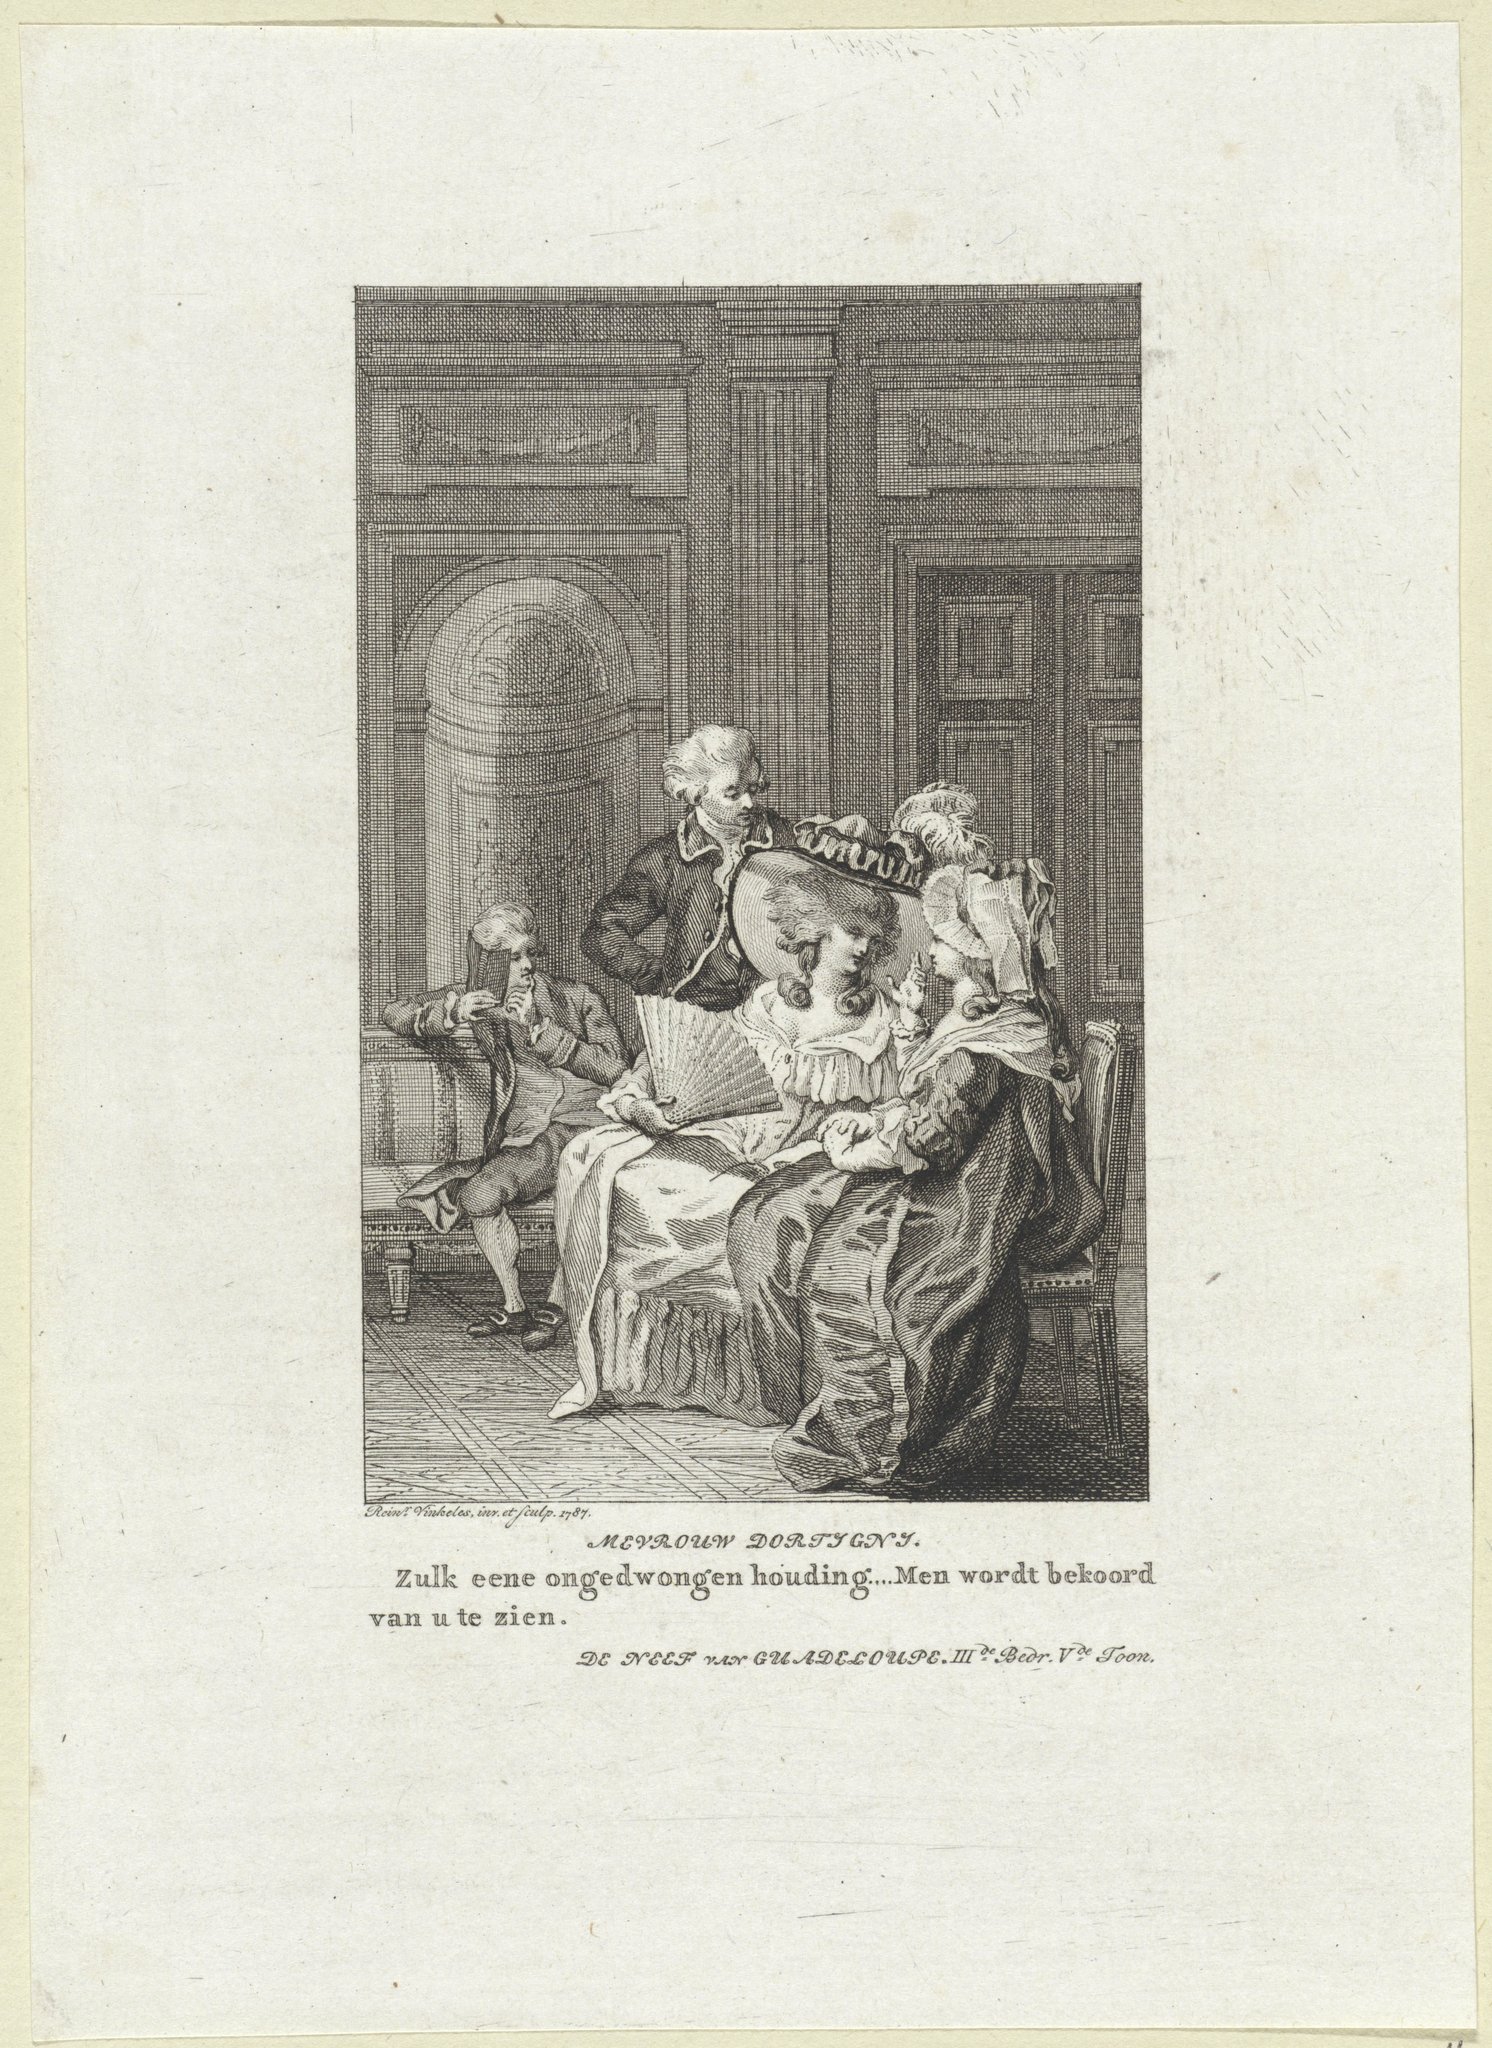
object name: print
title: Twee dames voeren een gesprek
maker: reinier vinkeles (i)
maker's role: draughtsman, print maker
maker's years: 1741-1816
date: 1787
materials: paper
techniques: engraving, etching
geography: amsterdam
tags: reading, fan, conversation, dialogue; conversation piece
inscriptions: collector's mark: Lugt 240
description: Deze prent is mogelijk gebruikt als illustratie in: Mercier, Louis-Sébastien. De Neef van Guadeloupe. Amsterdam: Erven van Pieter Meijer en Gerrit Warnars, 1787.